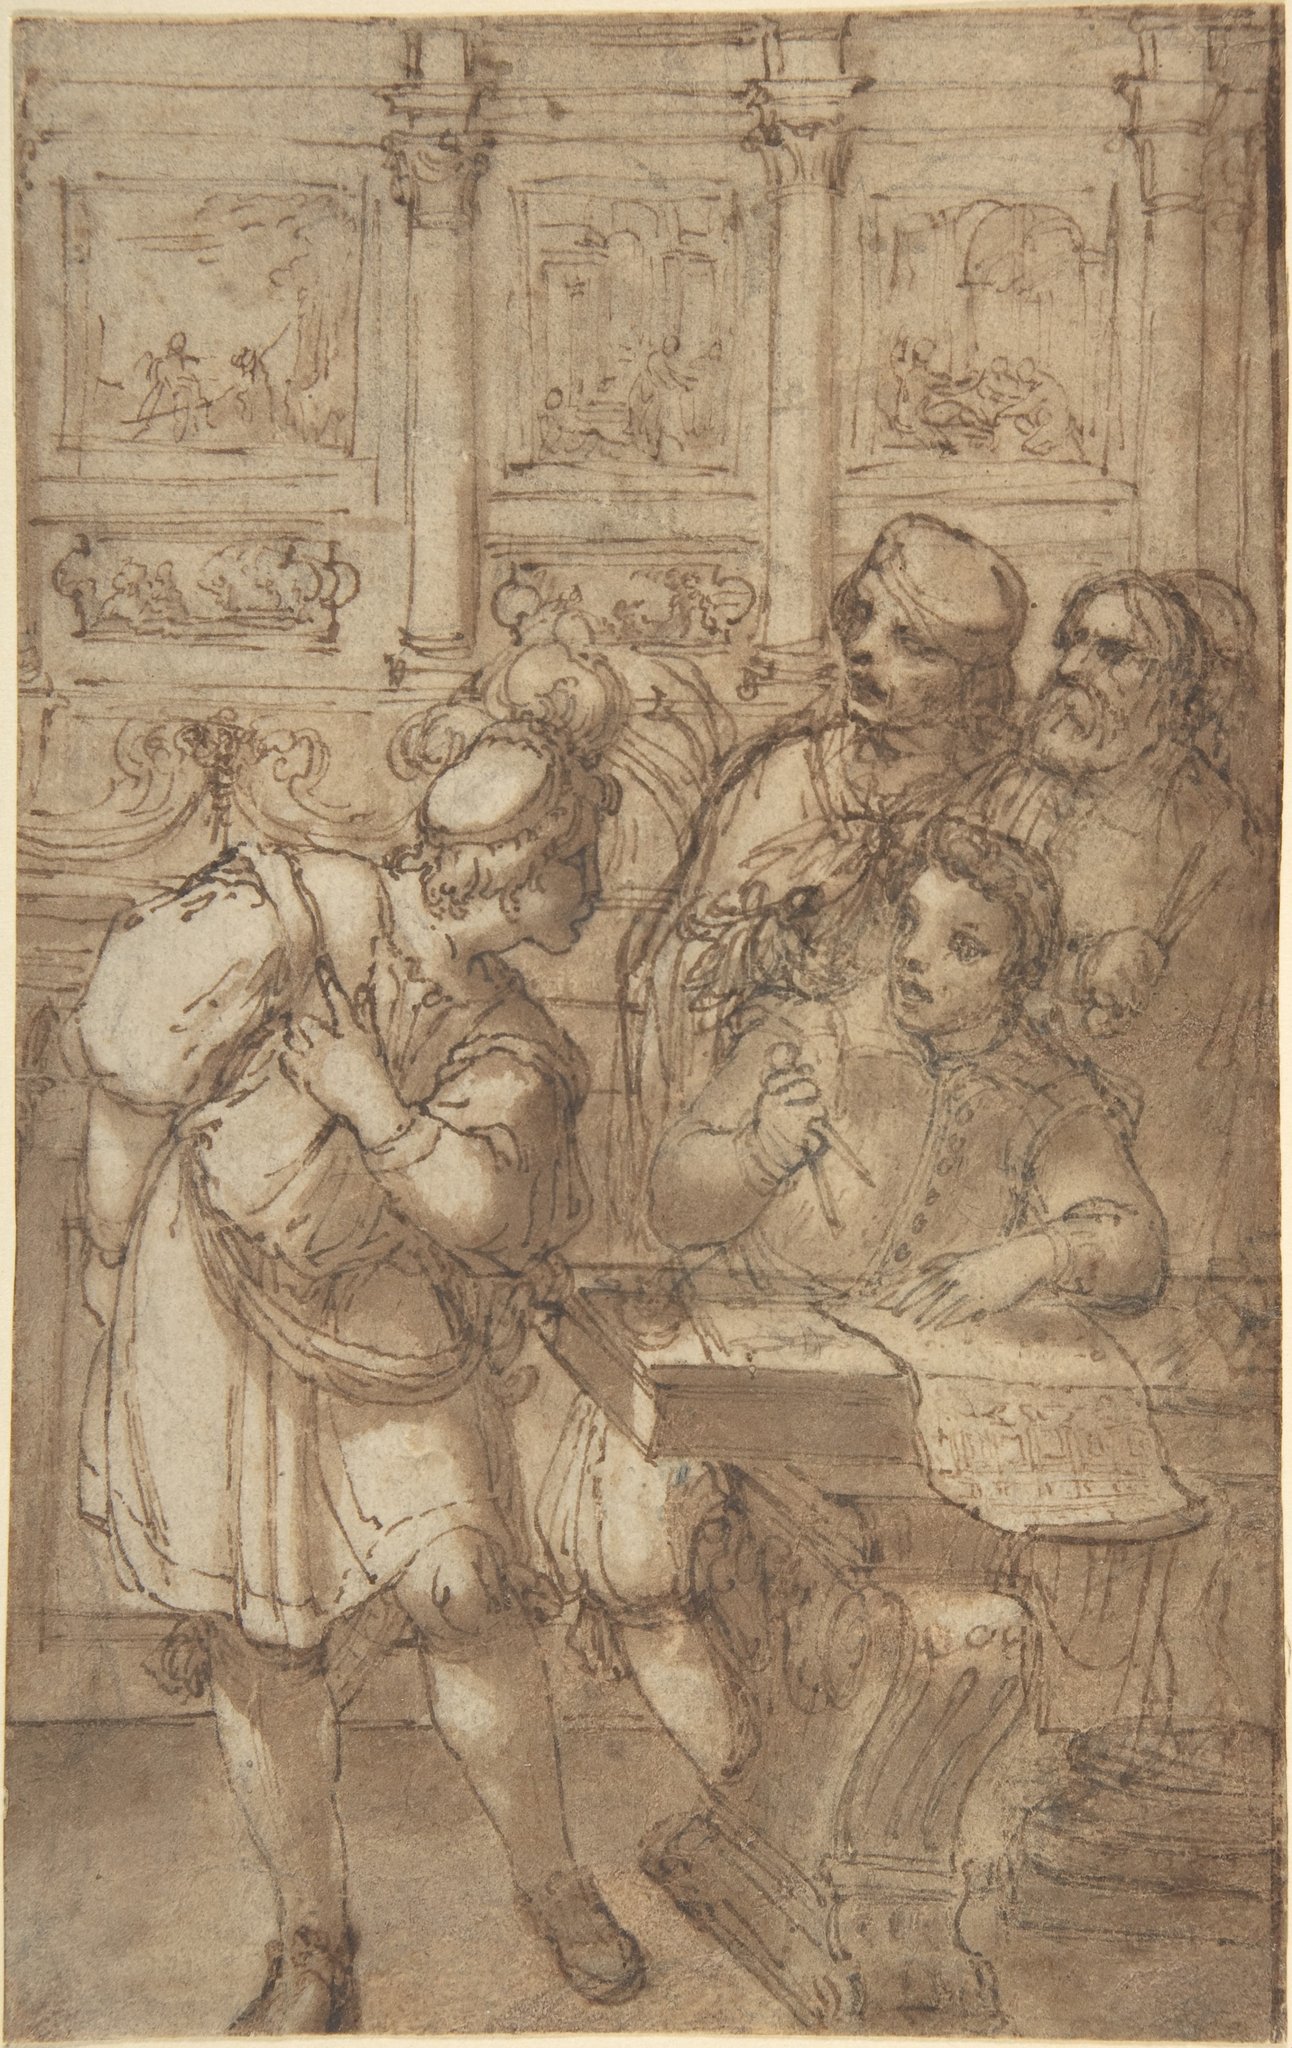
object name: drawing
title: Architect in His Study Holding a Compass and Conversing with Three Men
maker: agostino tassi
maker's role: artist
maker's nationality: italian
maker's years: 1580-1644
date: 1601-1700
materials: chalk, ink, paper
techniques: brush, pen, wash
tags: men,architects